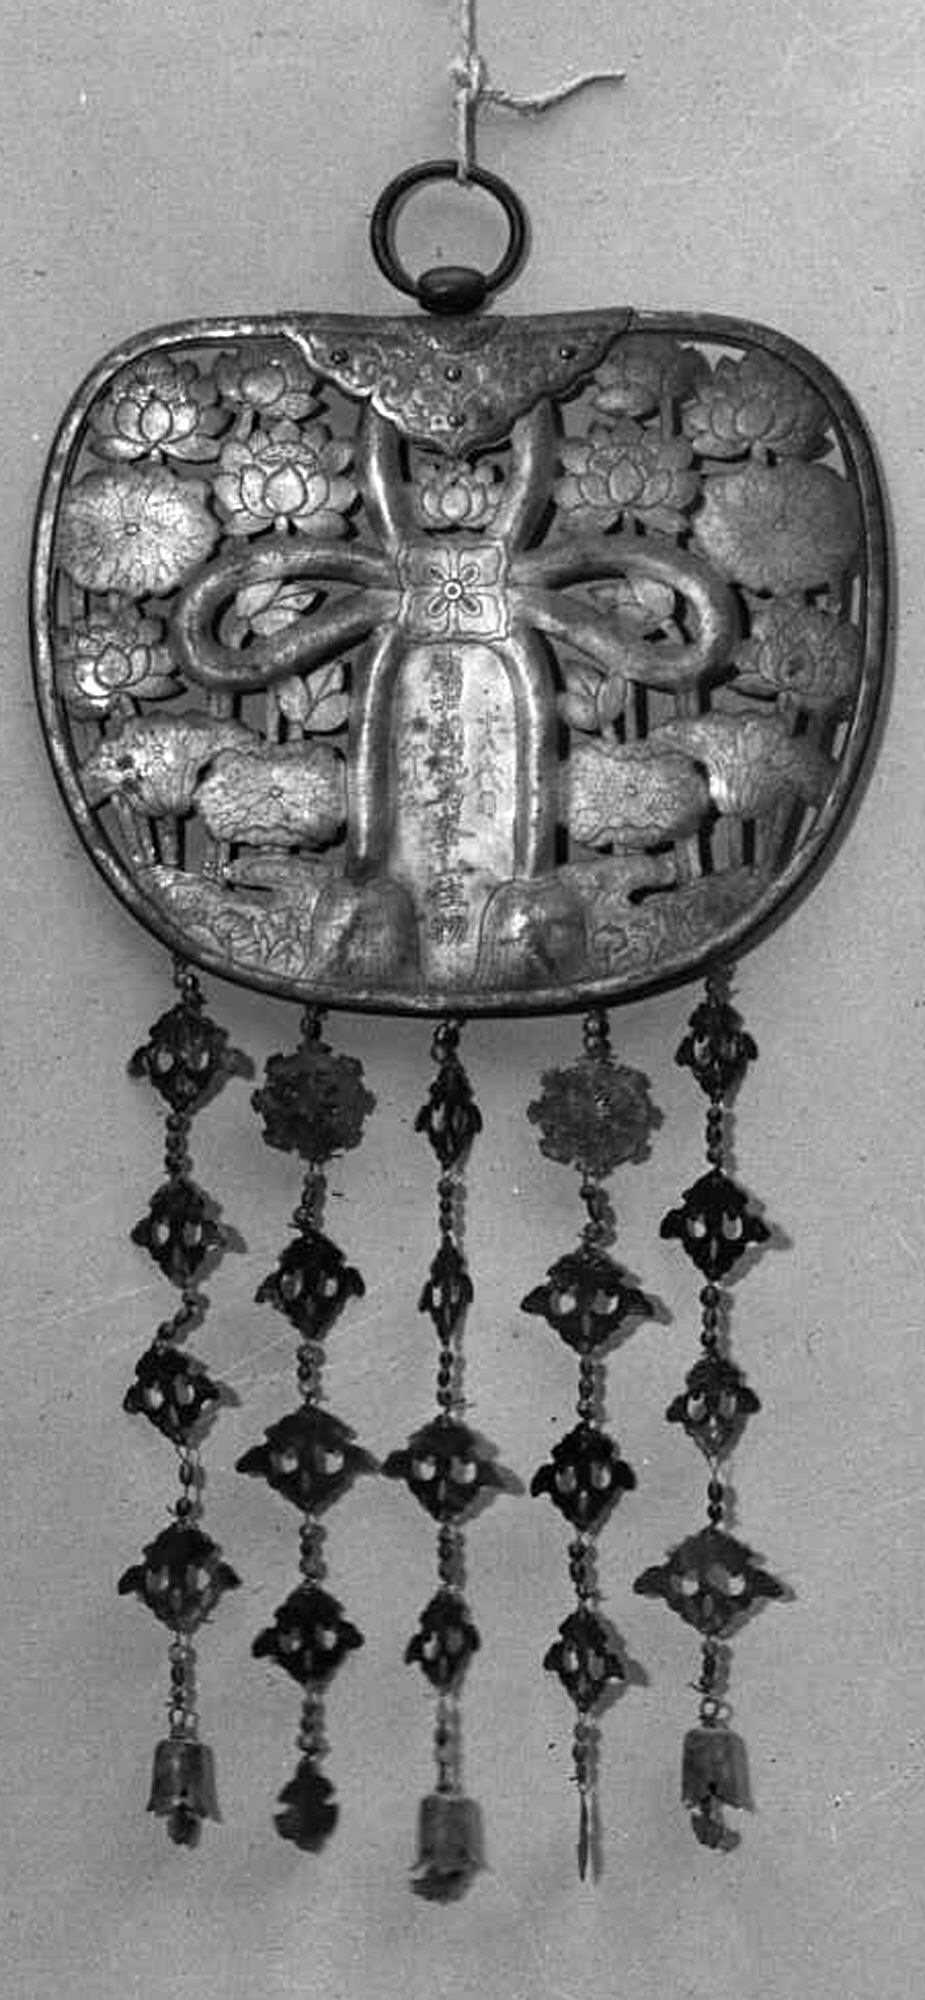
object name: temple decoration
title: Keman (“Flower Garland” Temple Decoration)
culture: japanese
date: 1725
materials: bronze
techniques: gilding